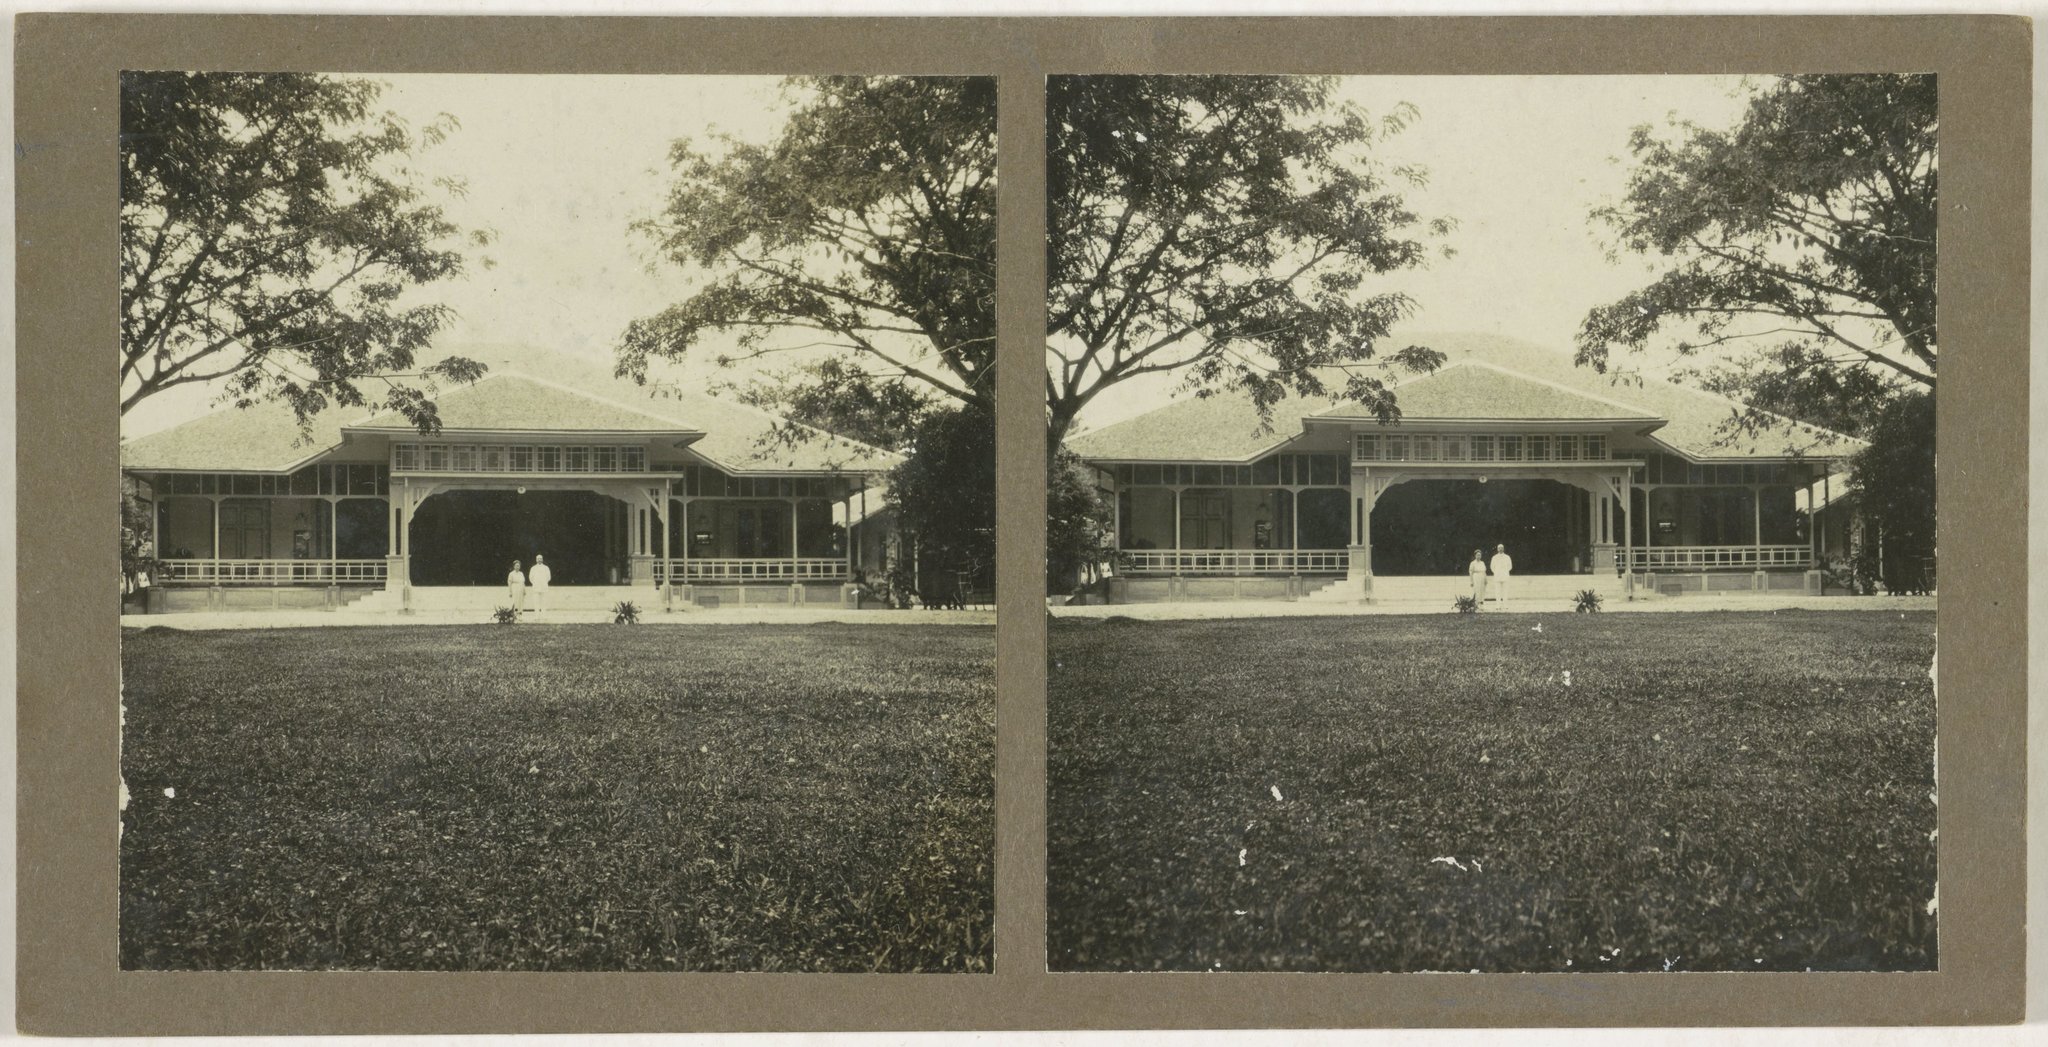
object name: stereograph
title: Man en vrouw poseren voor een landhuis, mogelijk op Borneo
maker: Anonymous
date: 1900-1940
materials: paper, cardboard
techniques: gelatin silver print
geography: indonesia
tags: villa, indonesia